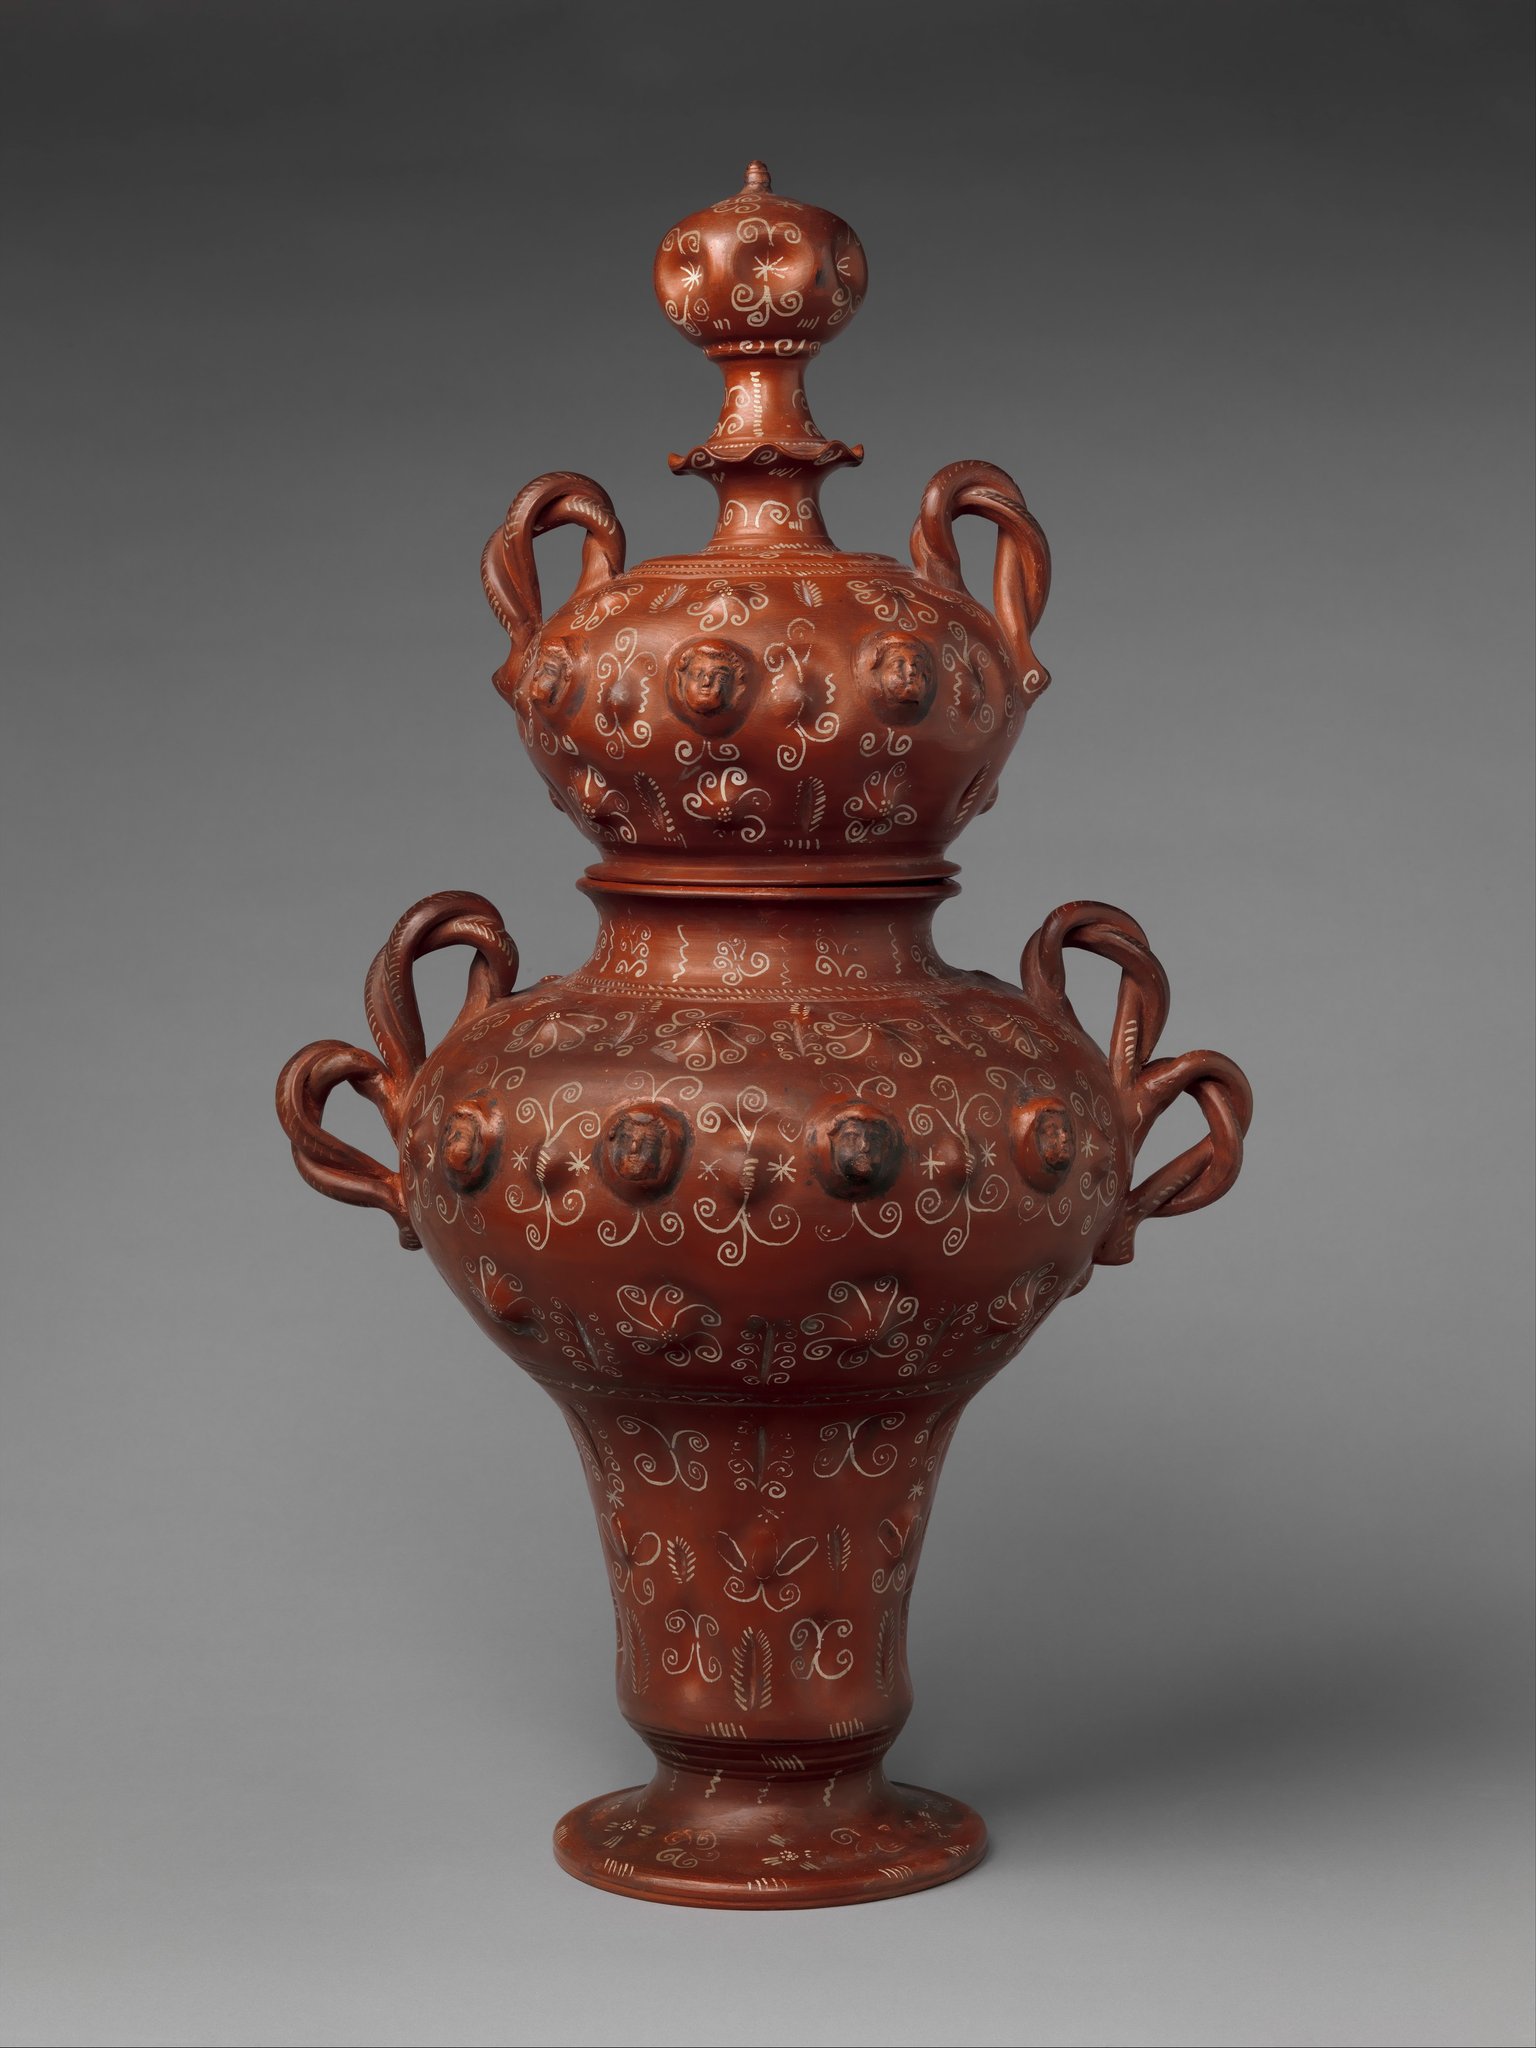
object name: covered jar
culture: mexican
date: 1675-1700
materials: earthenware, paint, silver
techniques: burnishing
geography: mexico